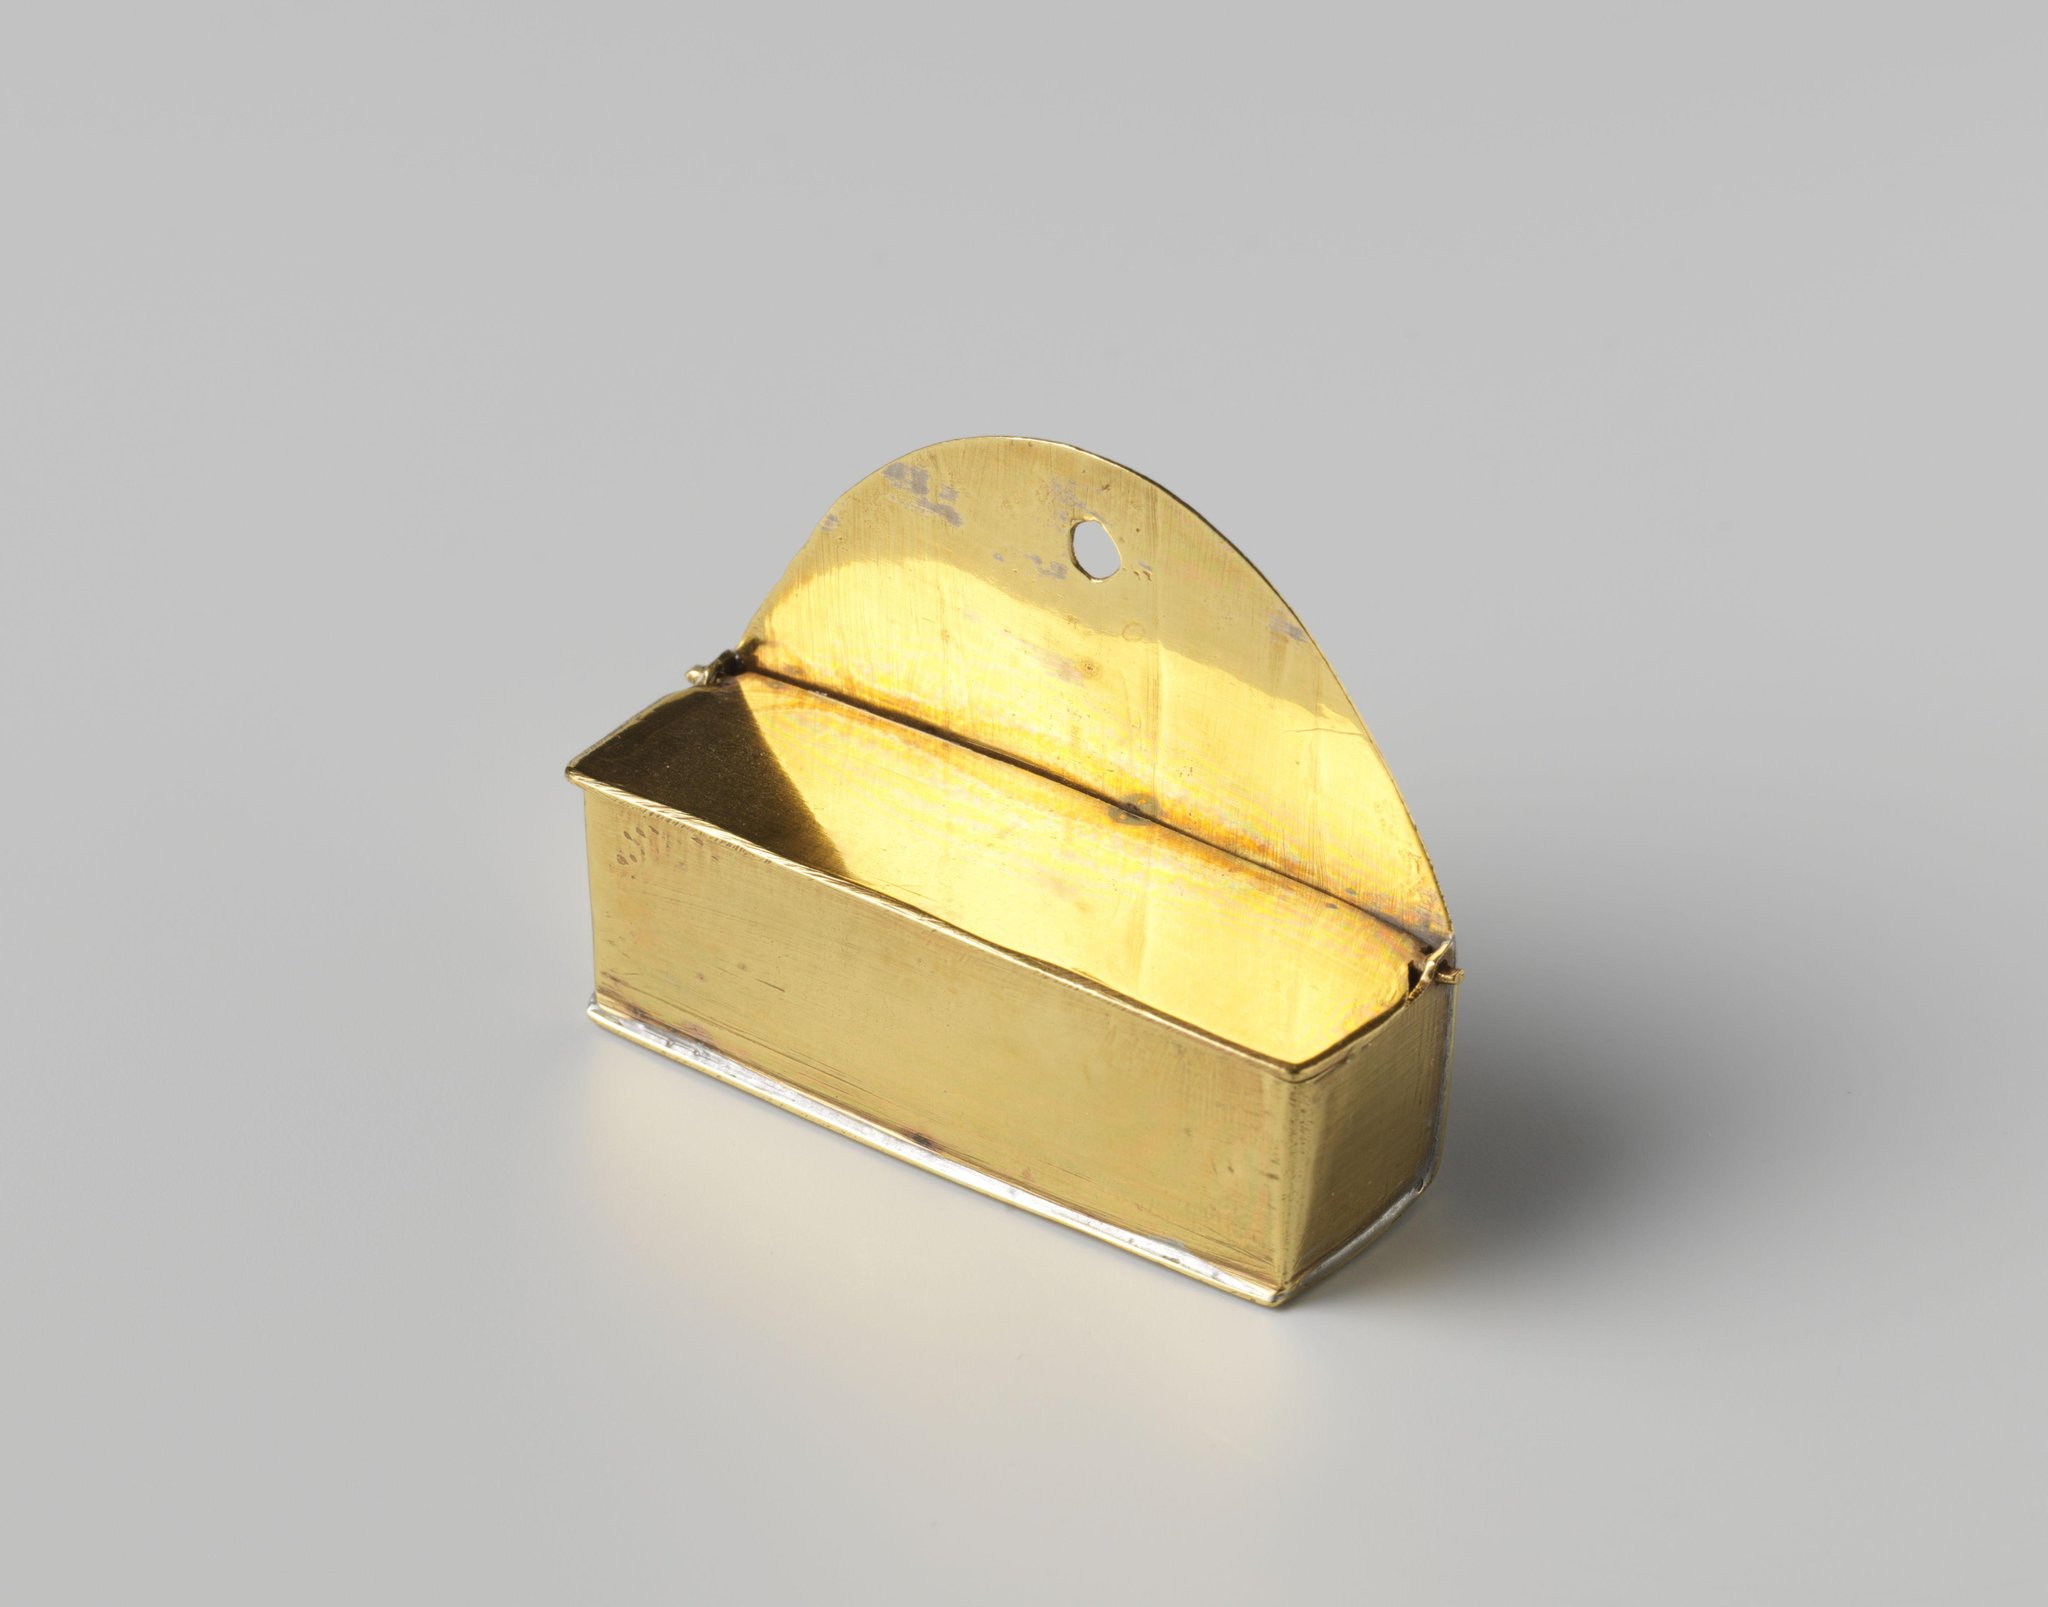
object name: kaarsenbak, kaarsenlade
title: Kaarsenbak, met halfronde achterplaat en scharnierend deksel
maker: Anonymous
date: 1700-1799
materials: brass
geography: amsterdam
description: Kaarsenbak van geelkoper, met halfronde achterplaat met ophanggat, scharnierende deksel.